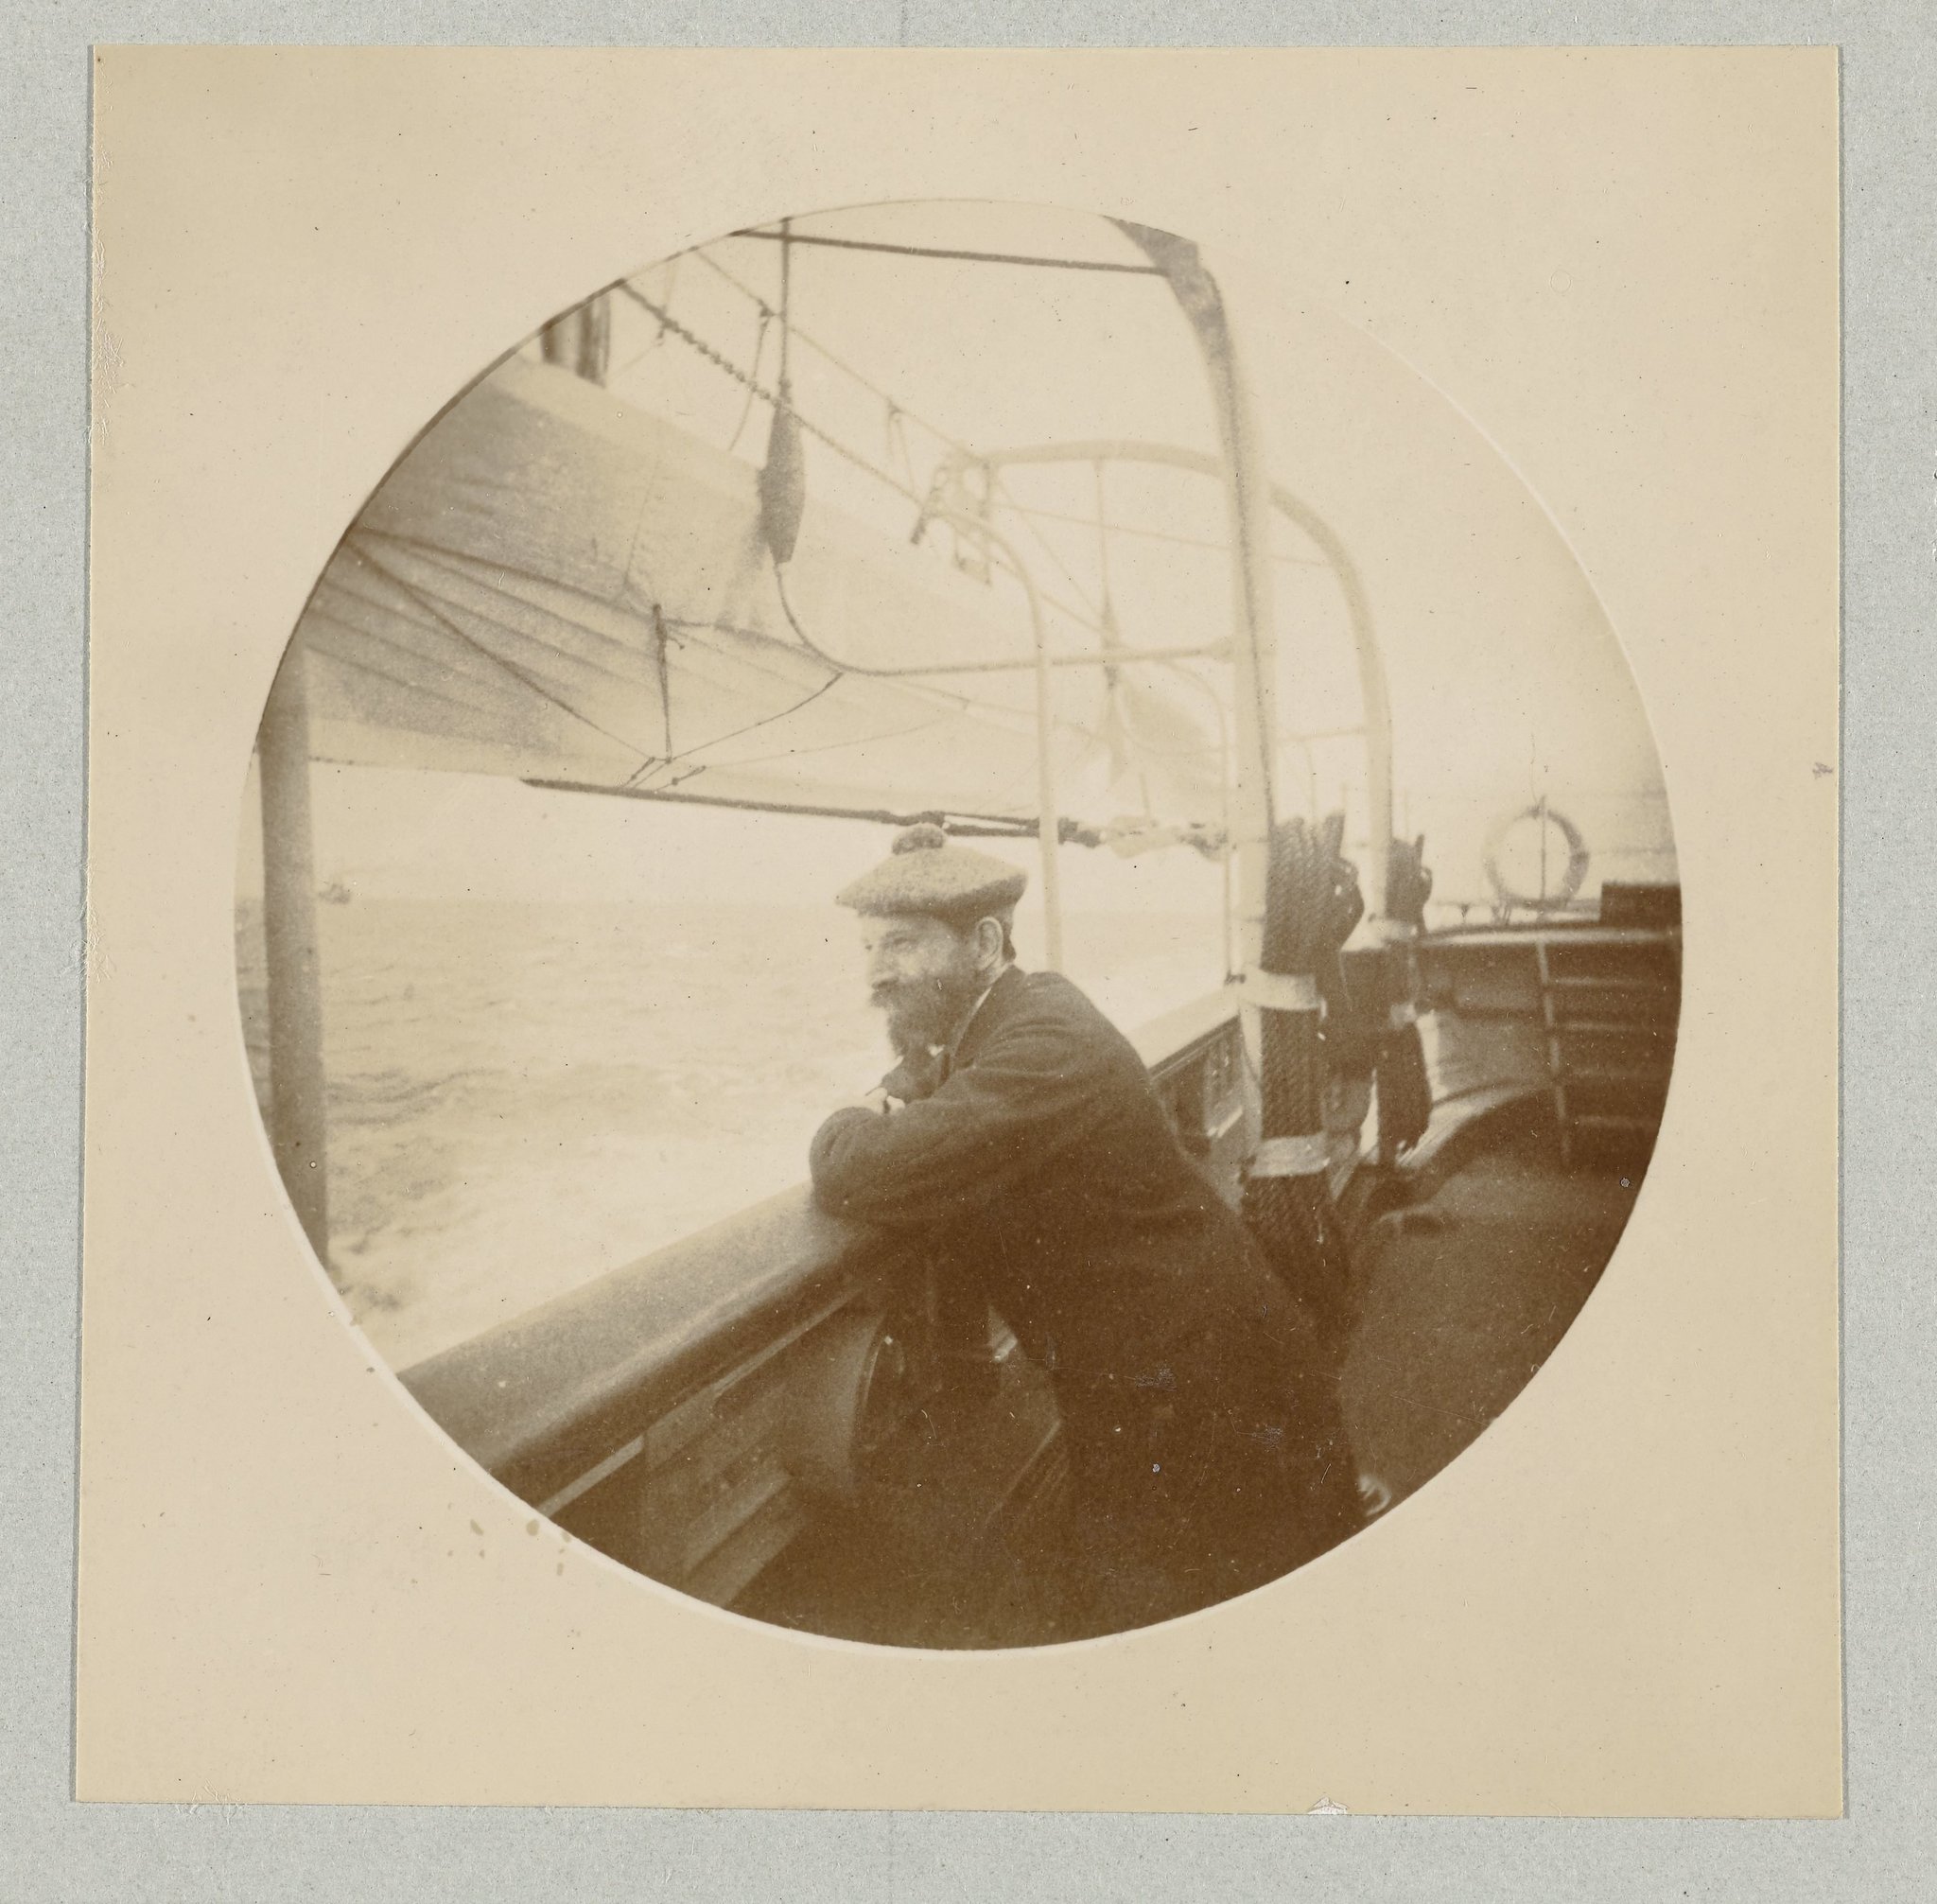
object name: photograph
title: Auf der fahrt nach Bodö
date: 1807-1889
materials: cardboard, paper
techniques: gelatin silver print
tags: wilhelm ii (keizer van duitsland), norway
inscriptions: number: ‘23’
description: De afdruk van de foto is rond, het papier vierkant. foto gemaakt met Nr. 1 Kodak Camera